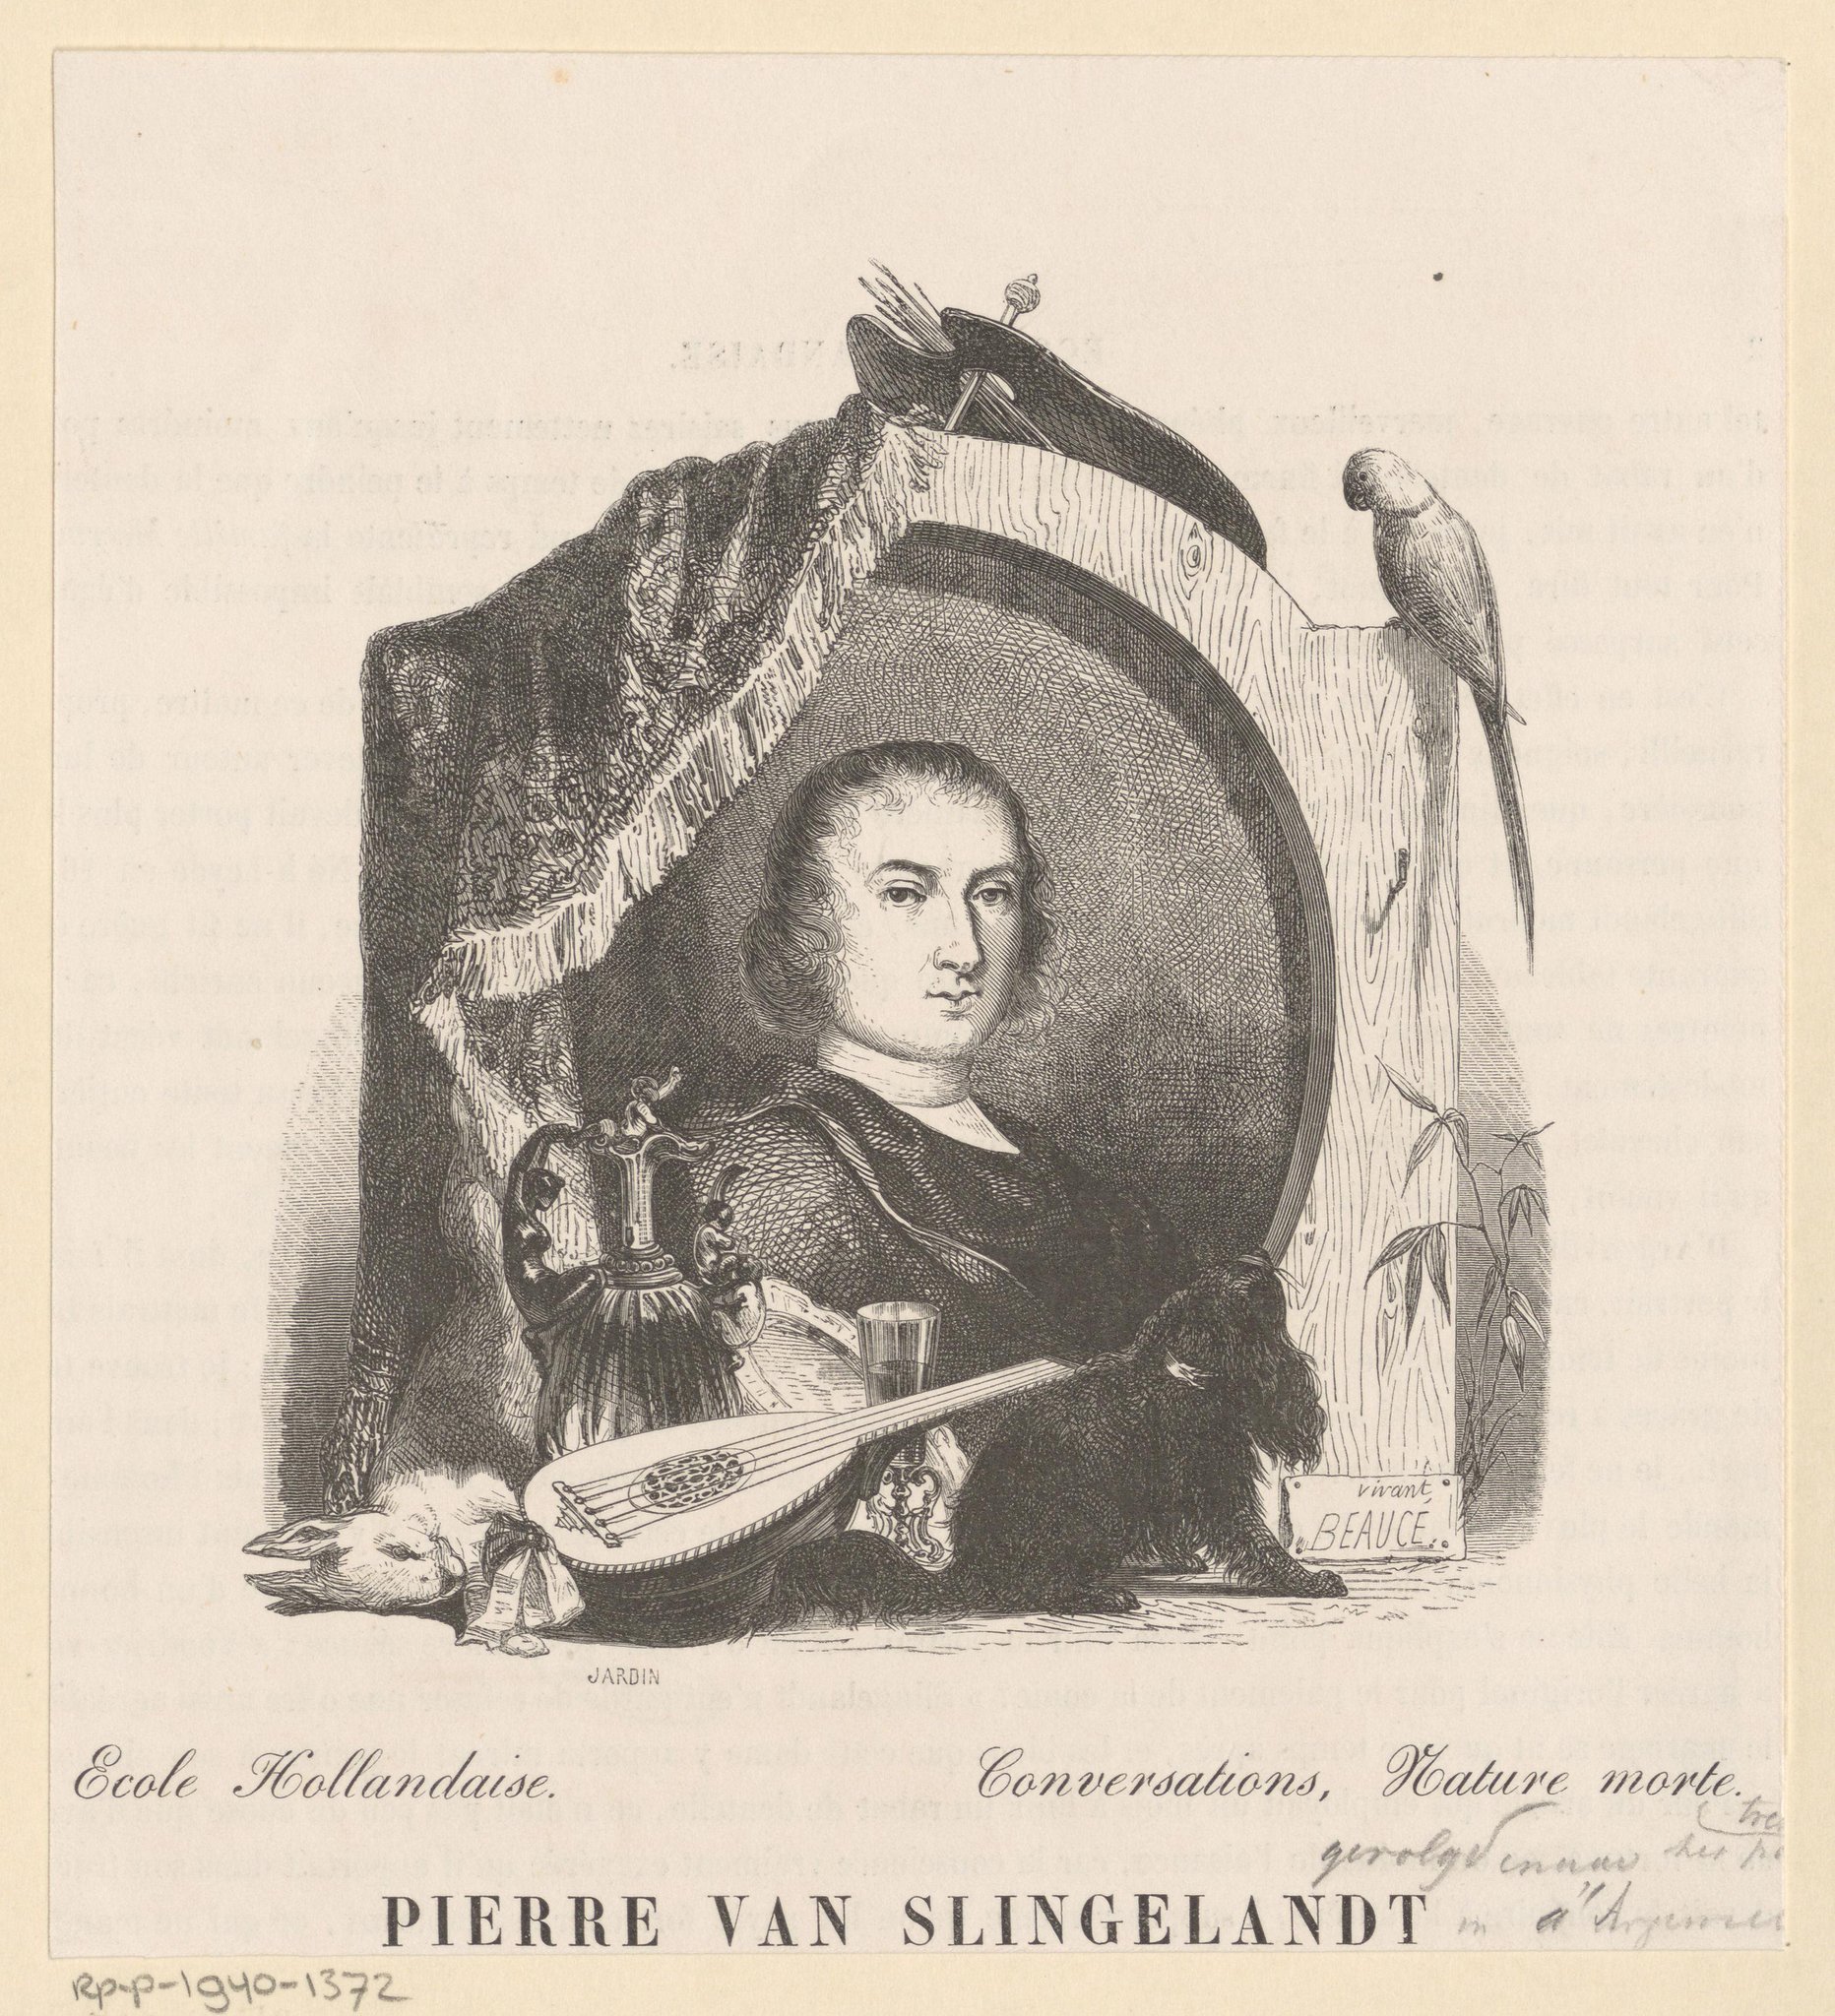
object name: book illustration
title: Portret van Pieter Cornelisz. van Slingelandt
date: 1861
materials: paper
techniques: letterpress printing, engraving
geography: paris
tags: draughtsman, pieter cornelisz. van slingelandt, historical persons, portrait, self-portrait of artist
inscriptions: collector's mark: Lugt 2760, collector's mark: Lugt 2228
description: Prent uit: Blanc, Charles M. Histoire des peintres de toutes les écoles. Parijs: Henri Loones, 1861, dl. 2.